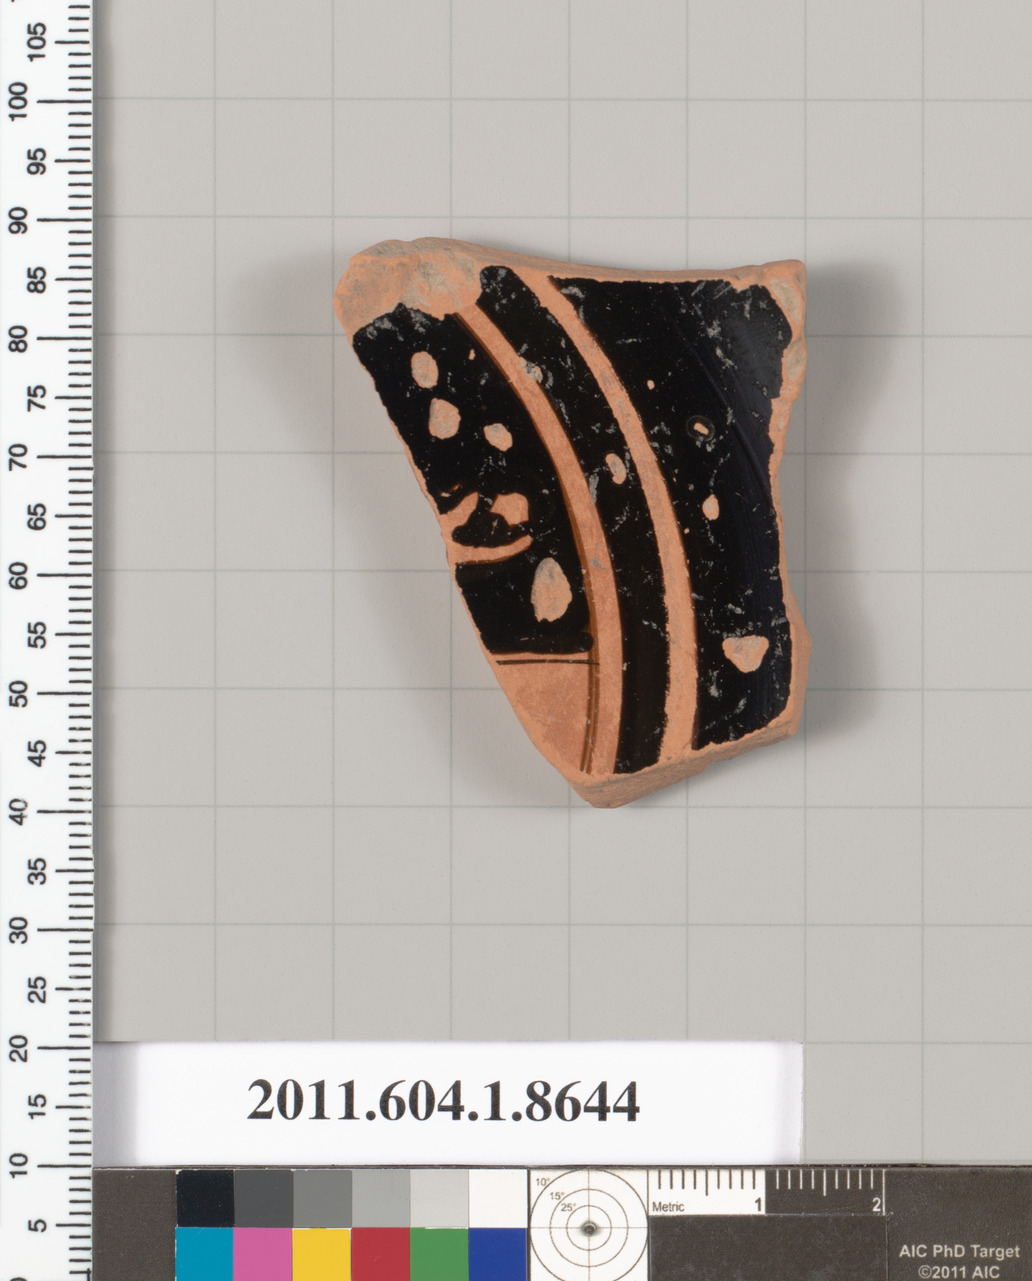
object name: kylix fragment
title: Terracotta fragment of a stemless kylix (drinking cup)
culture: greek, attic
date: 467-435 BCE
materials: terracotta